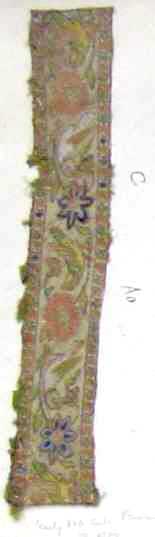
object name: textile fragment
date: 1601-1700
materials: silk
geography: iran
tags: flowers